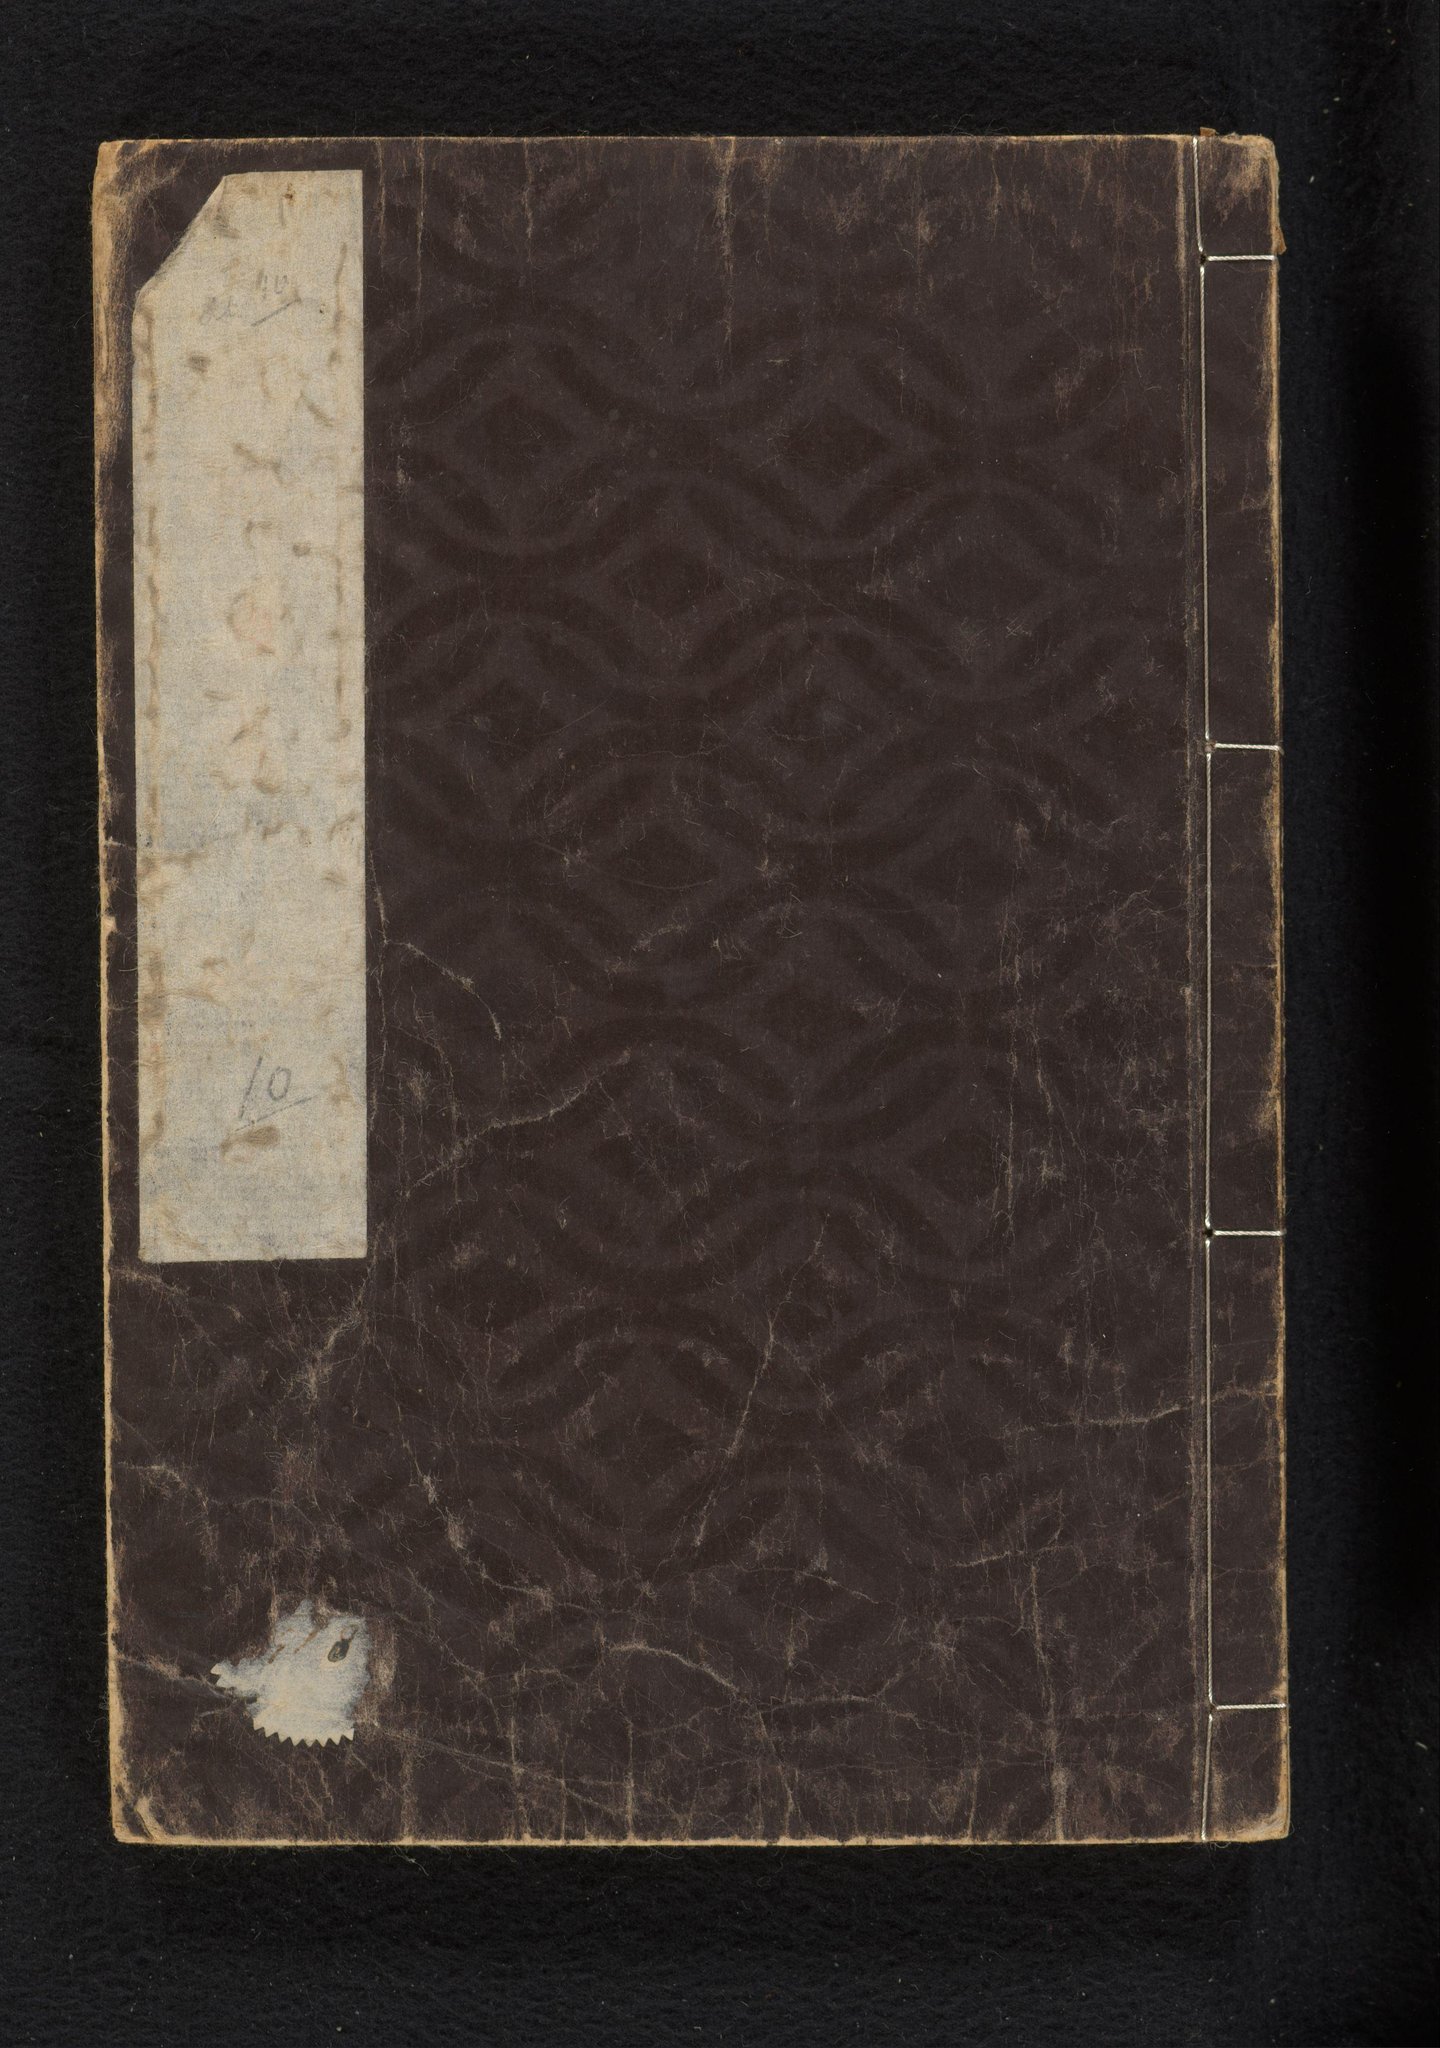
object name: book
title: Schetsen van Hokusai - deel 10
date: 1819-1878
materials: paper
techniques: woodcut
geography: japan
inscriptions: inscription, collector's mark: ‘museum van aziatische kunst rijksmuseum Amsterdam-z.’